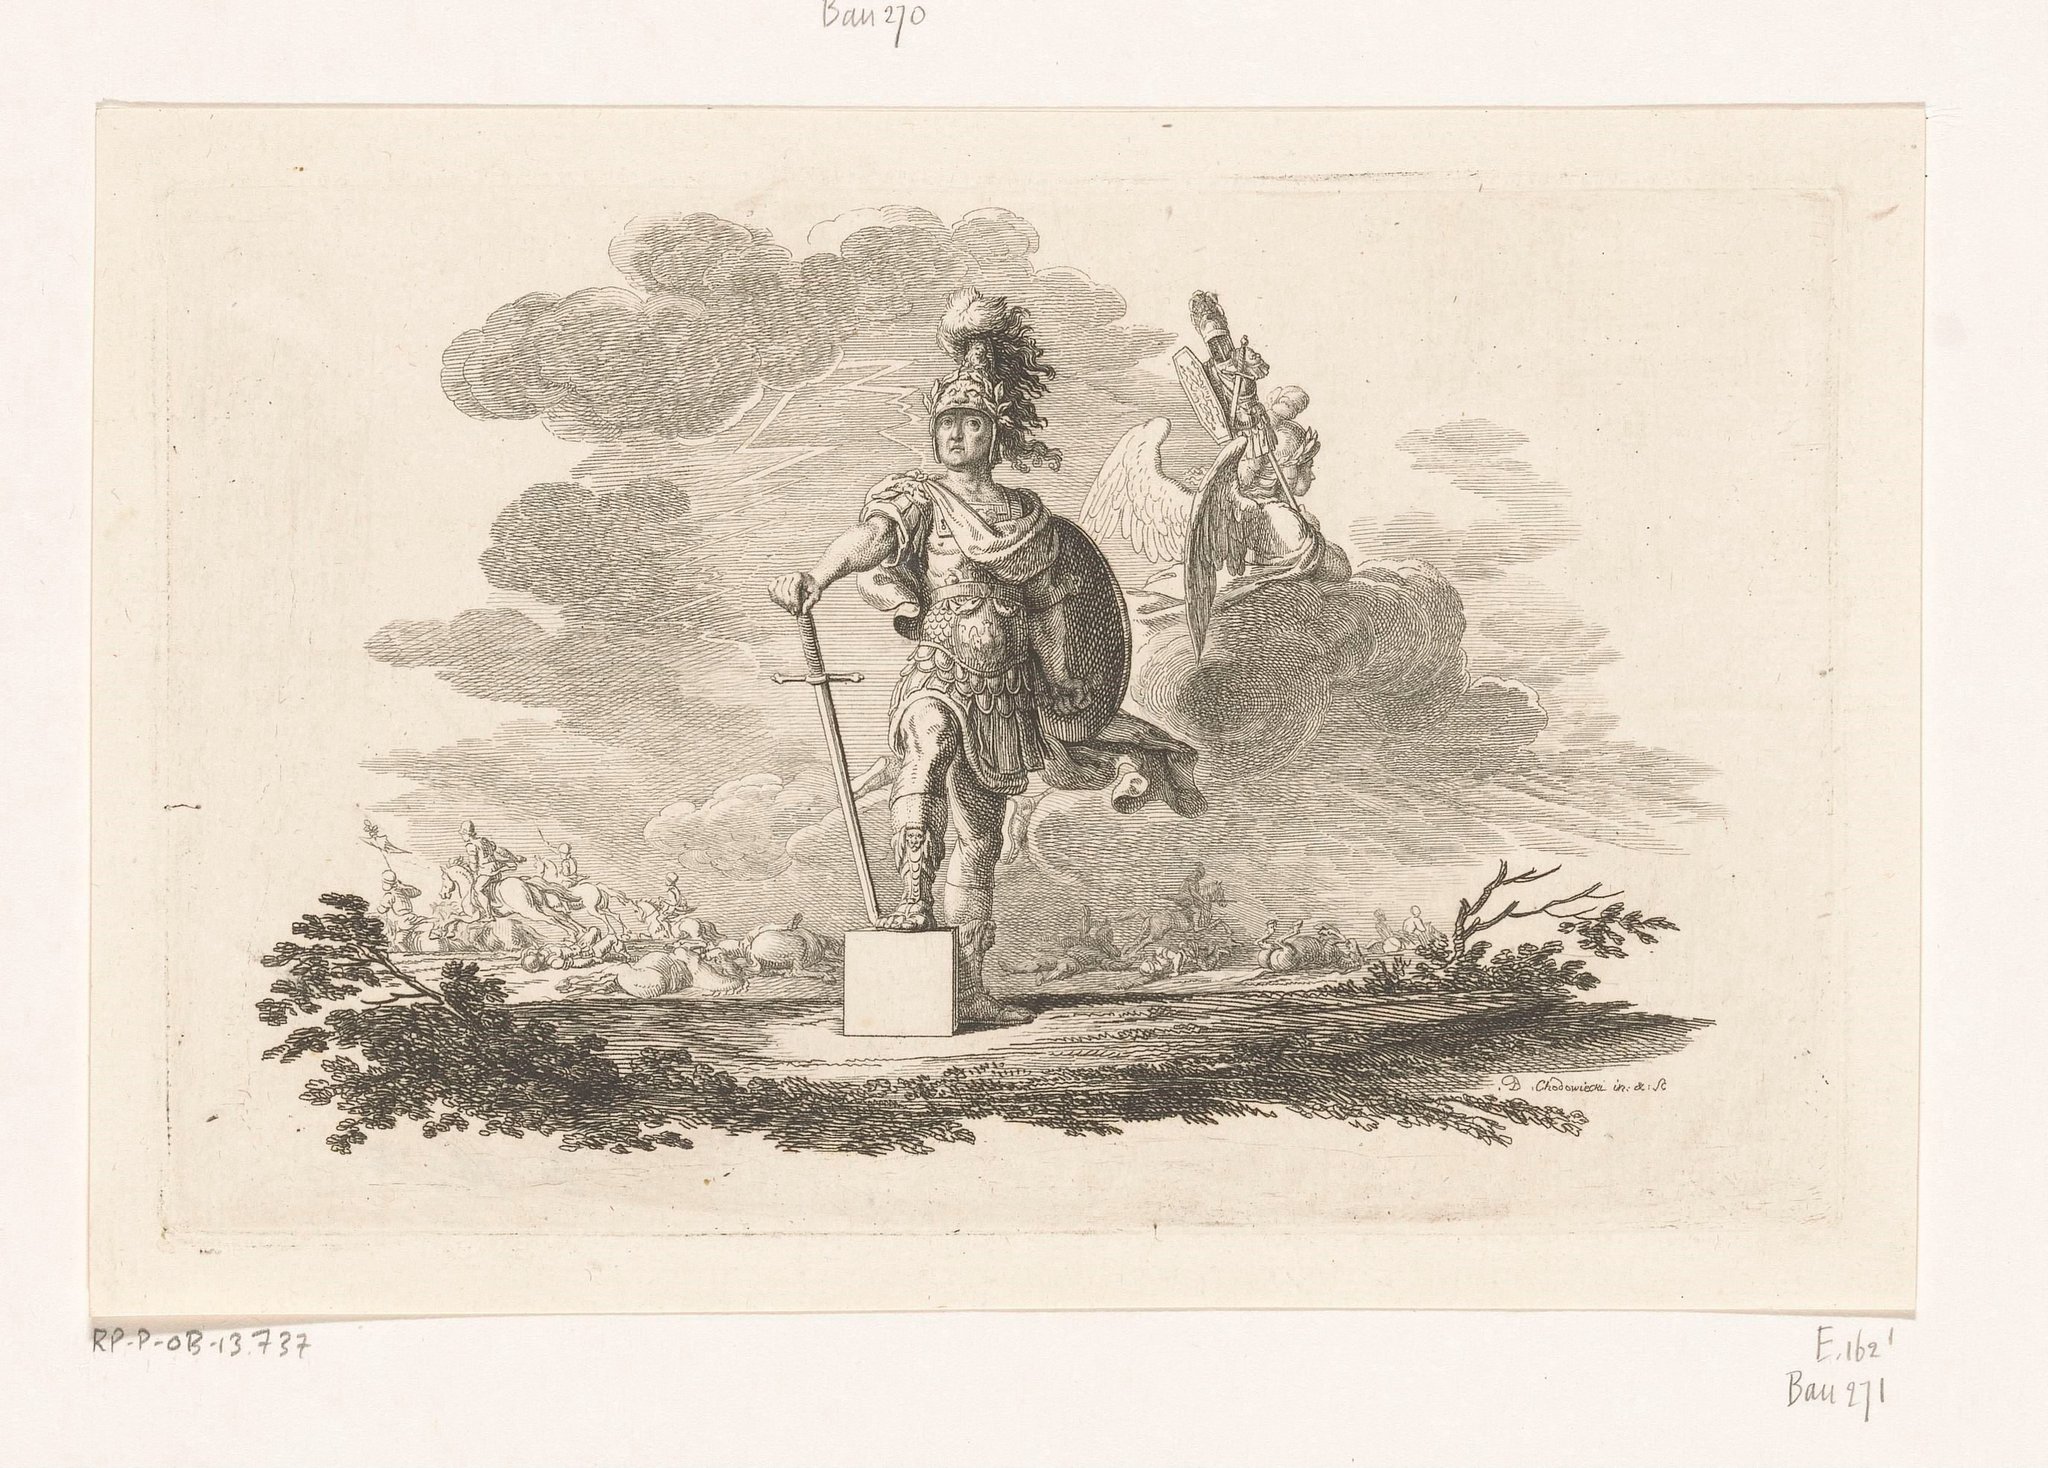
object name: print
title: Portret van Frederik de Grote als Romeins keizer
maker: daniel nikolaus chodowiecki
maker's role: draughtsman, print maker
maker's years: 1726-1801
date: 1776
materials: paper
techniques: etching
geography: berlin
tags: berlin, frederick ii (king of prussia), historical persons, emperor, lightning, flash of lightning, thunderbolt, (story of) nike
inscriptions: collector's mark: Lugt 2228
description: Oorspronkelijk droeg deze prent als onderschrift 'Friedrich im Unglück', een verwijzing naar nederlaag tijdens de Slag bij Kunersdorf (Kunowice) van 12 augustus 1759. Na kritiek verwijderde de kunstenaar deze verwijzing en werd de prent zonder dit opschrift afgedrukt. Deze prent is een eerste staat, voor toevoeging van het gewraakte opschrift. De derde staat van deze prent is ook gebruikt in: Tielcke, Johann Gottlieb. Mémoires pour servir à l'art et l'histoire de la guerre de 1756. jusqu'à 1763. Freiberg, Barthel, 1777.